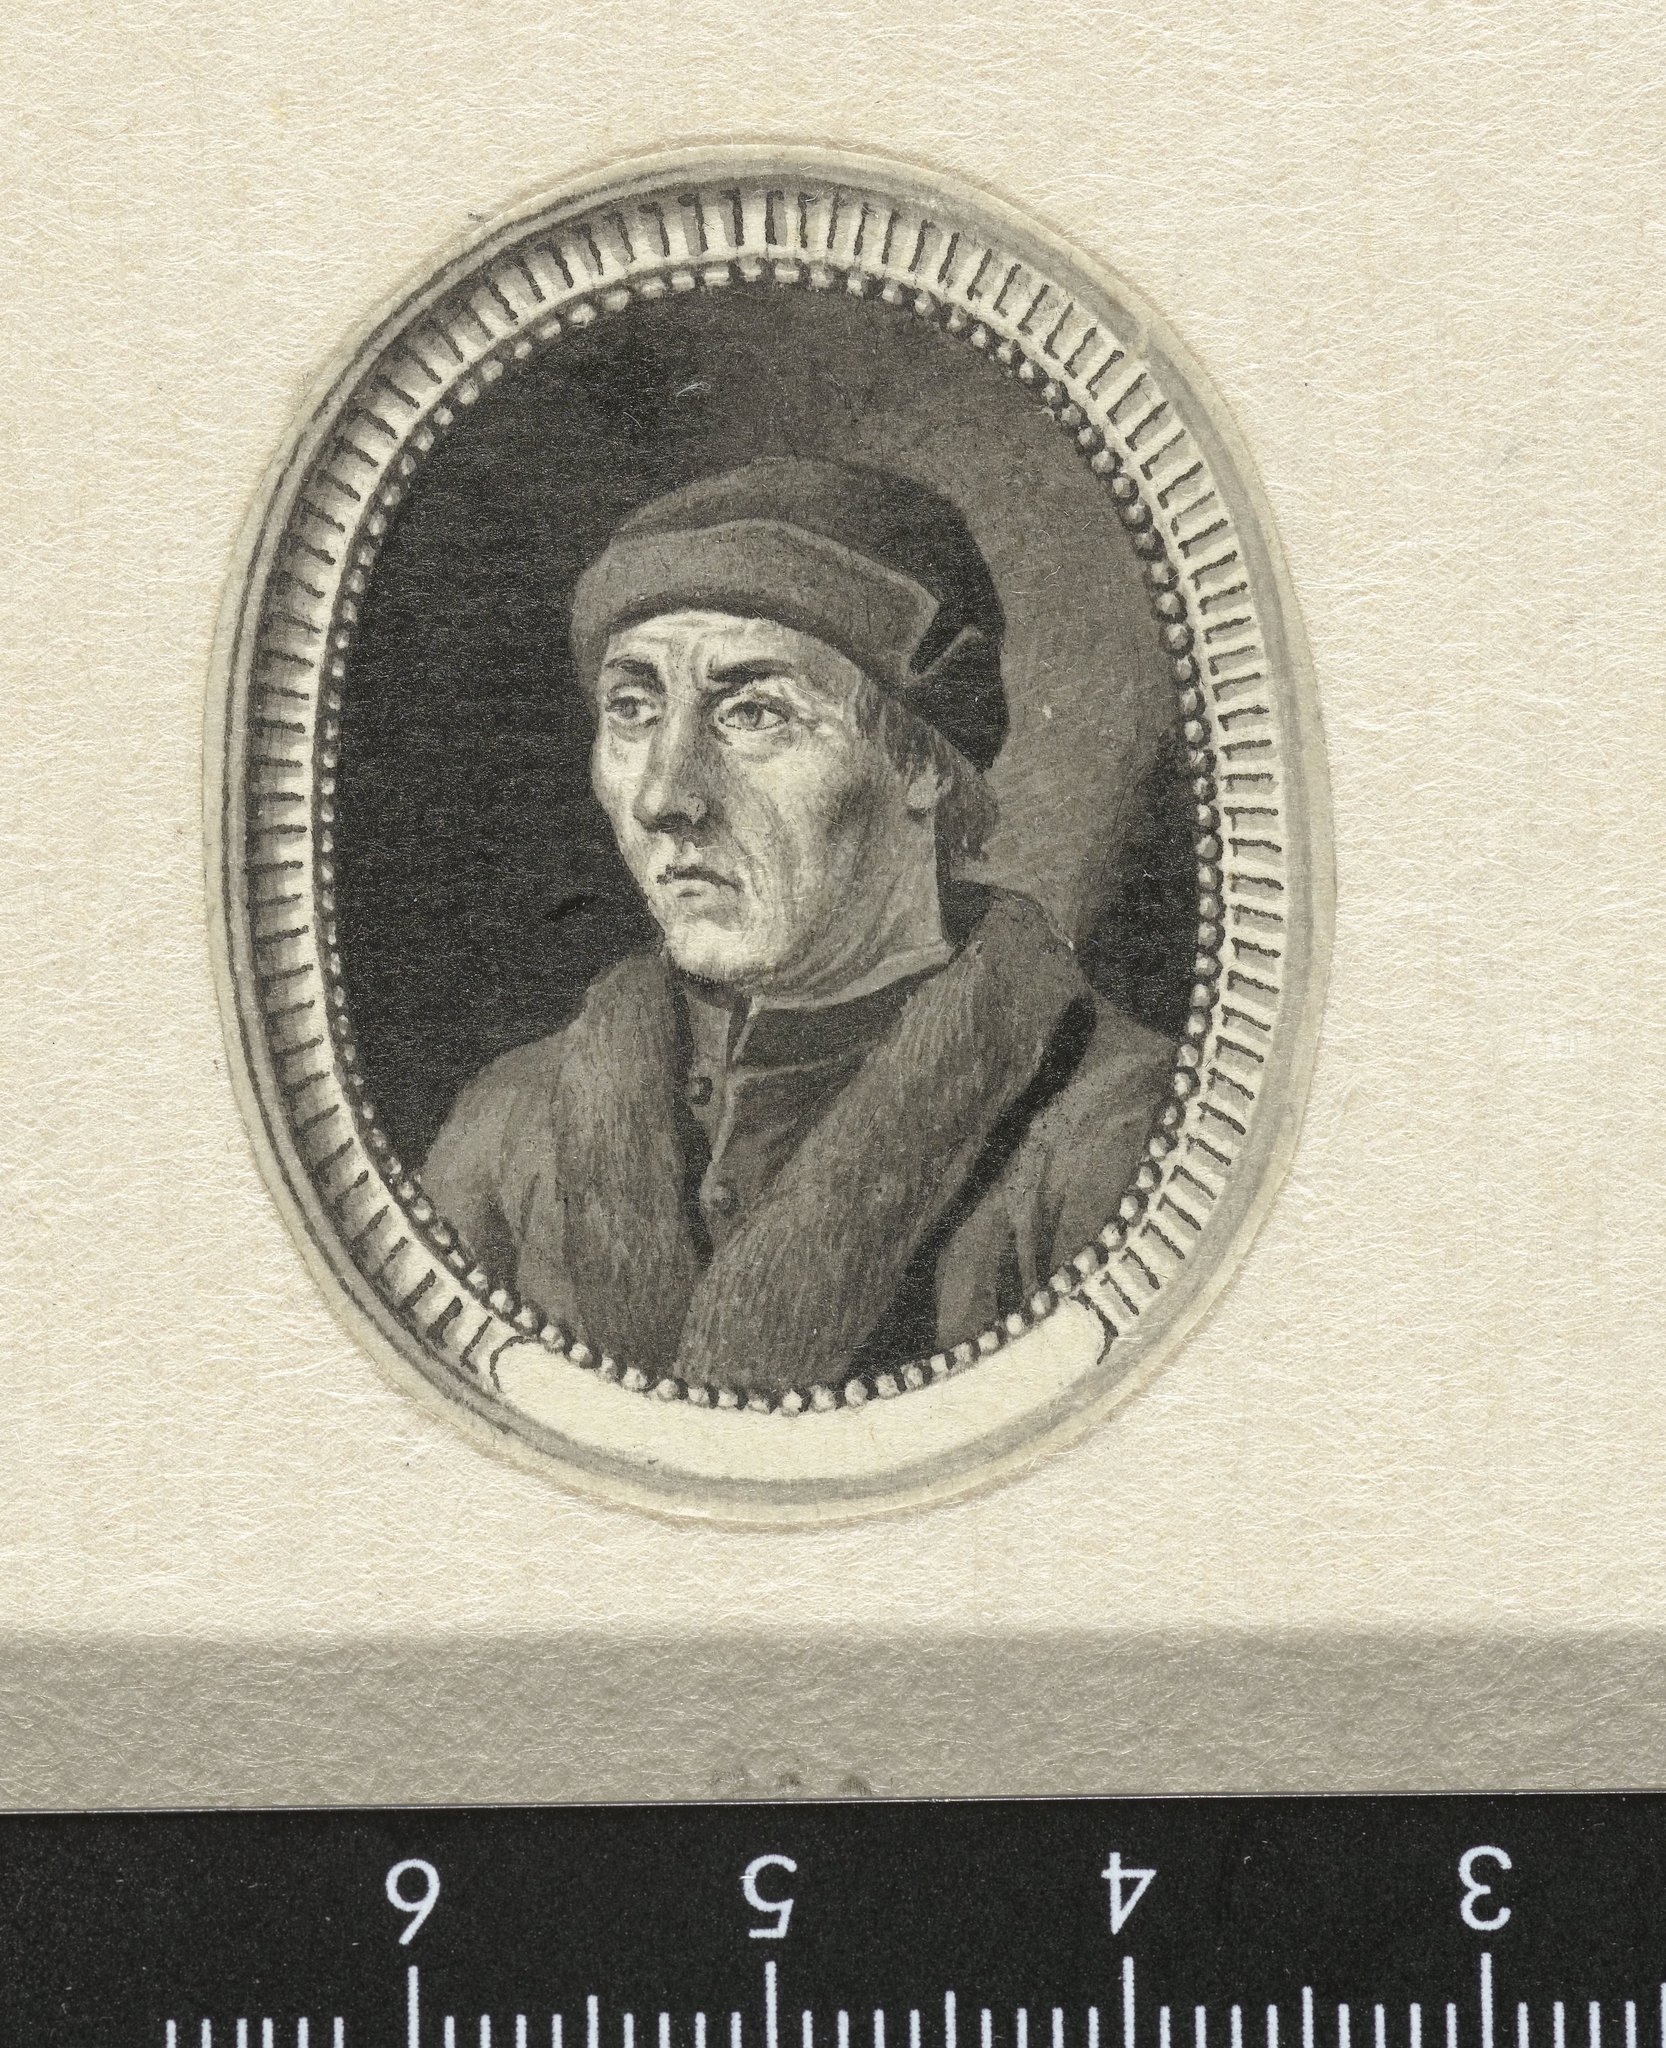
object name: drawing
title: Ovaal portret van Laurens Jansz. Coster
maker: jacques kuyper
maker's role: draughtsman, print maker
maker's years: 1761-1808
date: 1771-1808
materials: ink, paper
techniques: brush, pen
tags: haarlem, historical persons